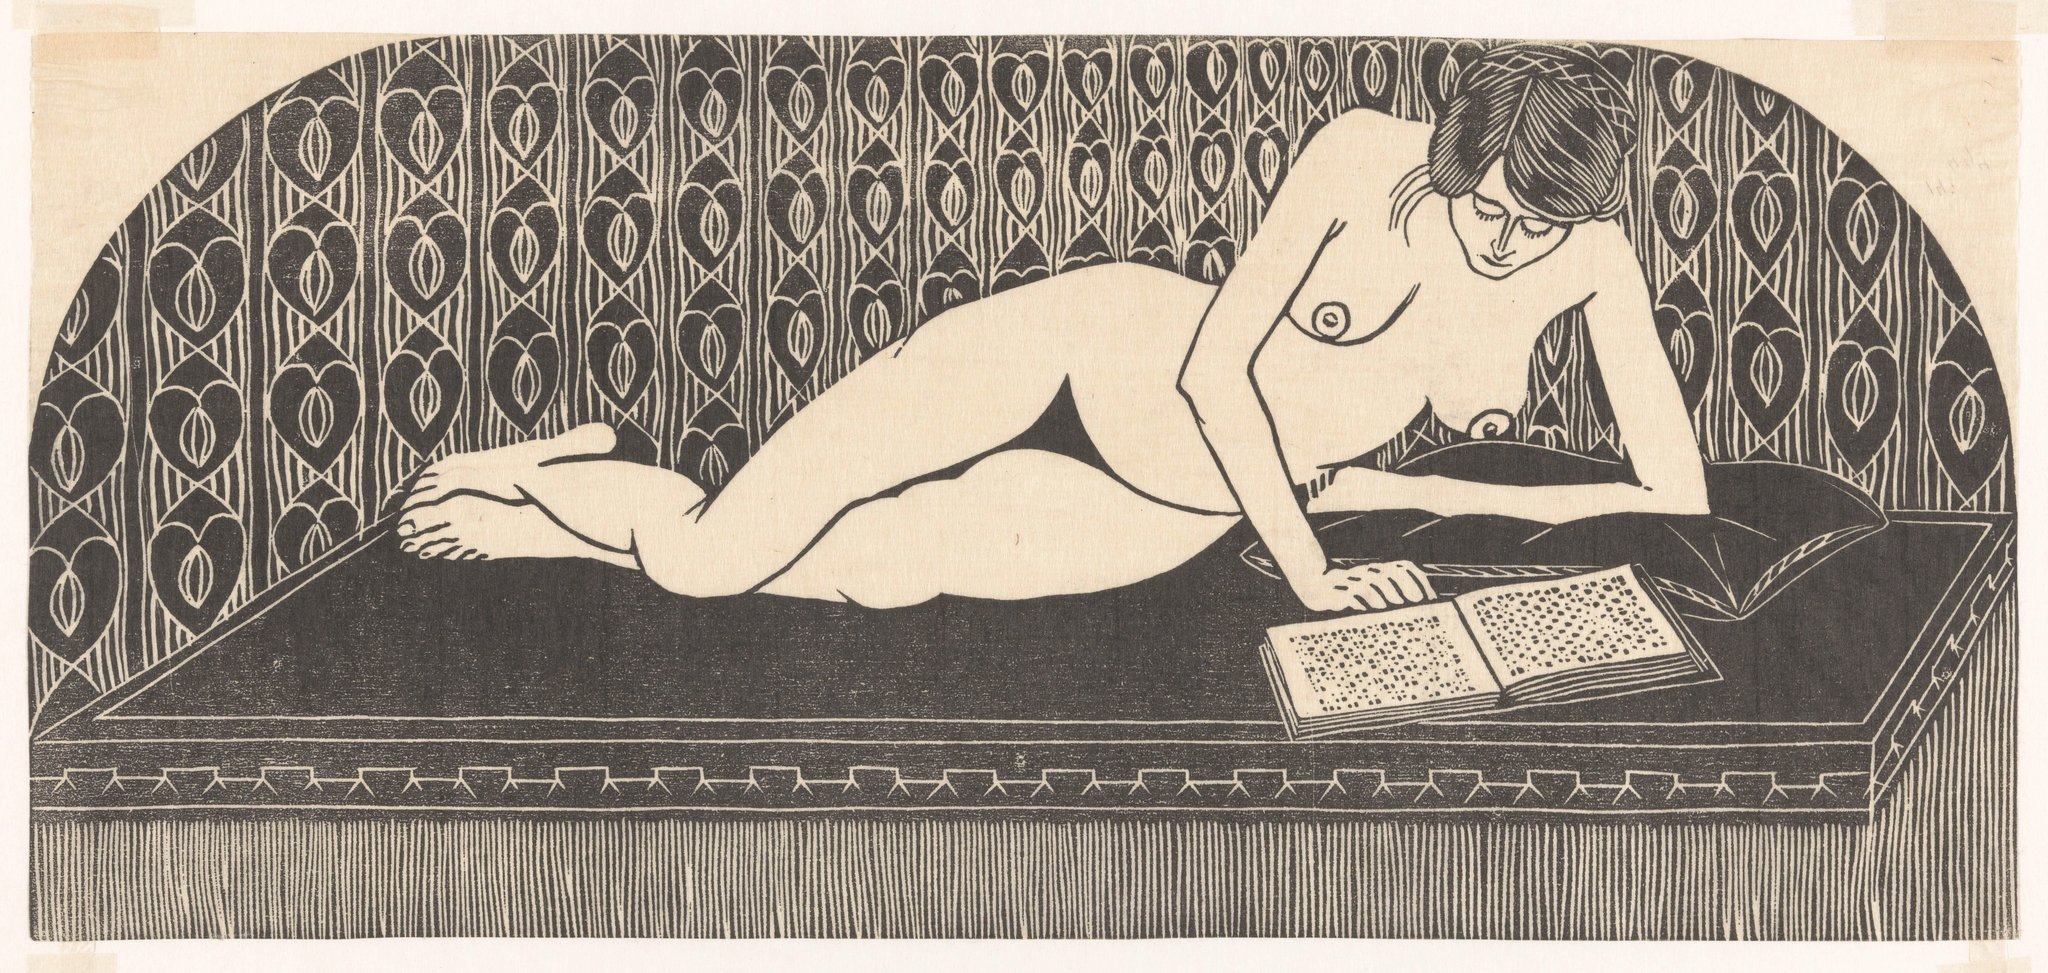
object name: print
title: Naaktstudie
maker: samuel jessurun de mesquita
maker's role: draughtsman, print maker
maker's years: 1868-1944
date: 1913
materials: paper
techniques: woodcut